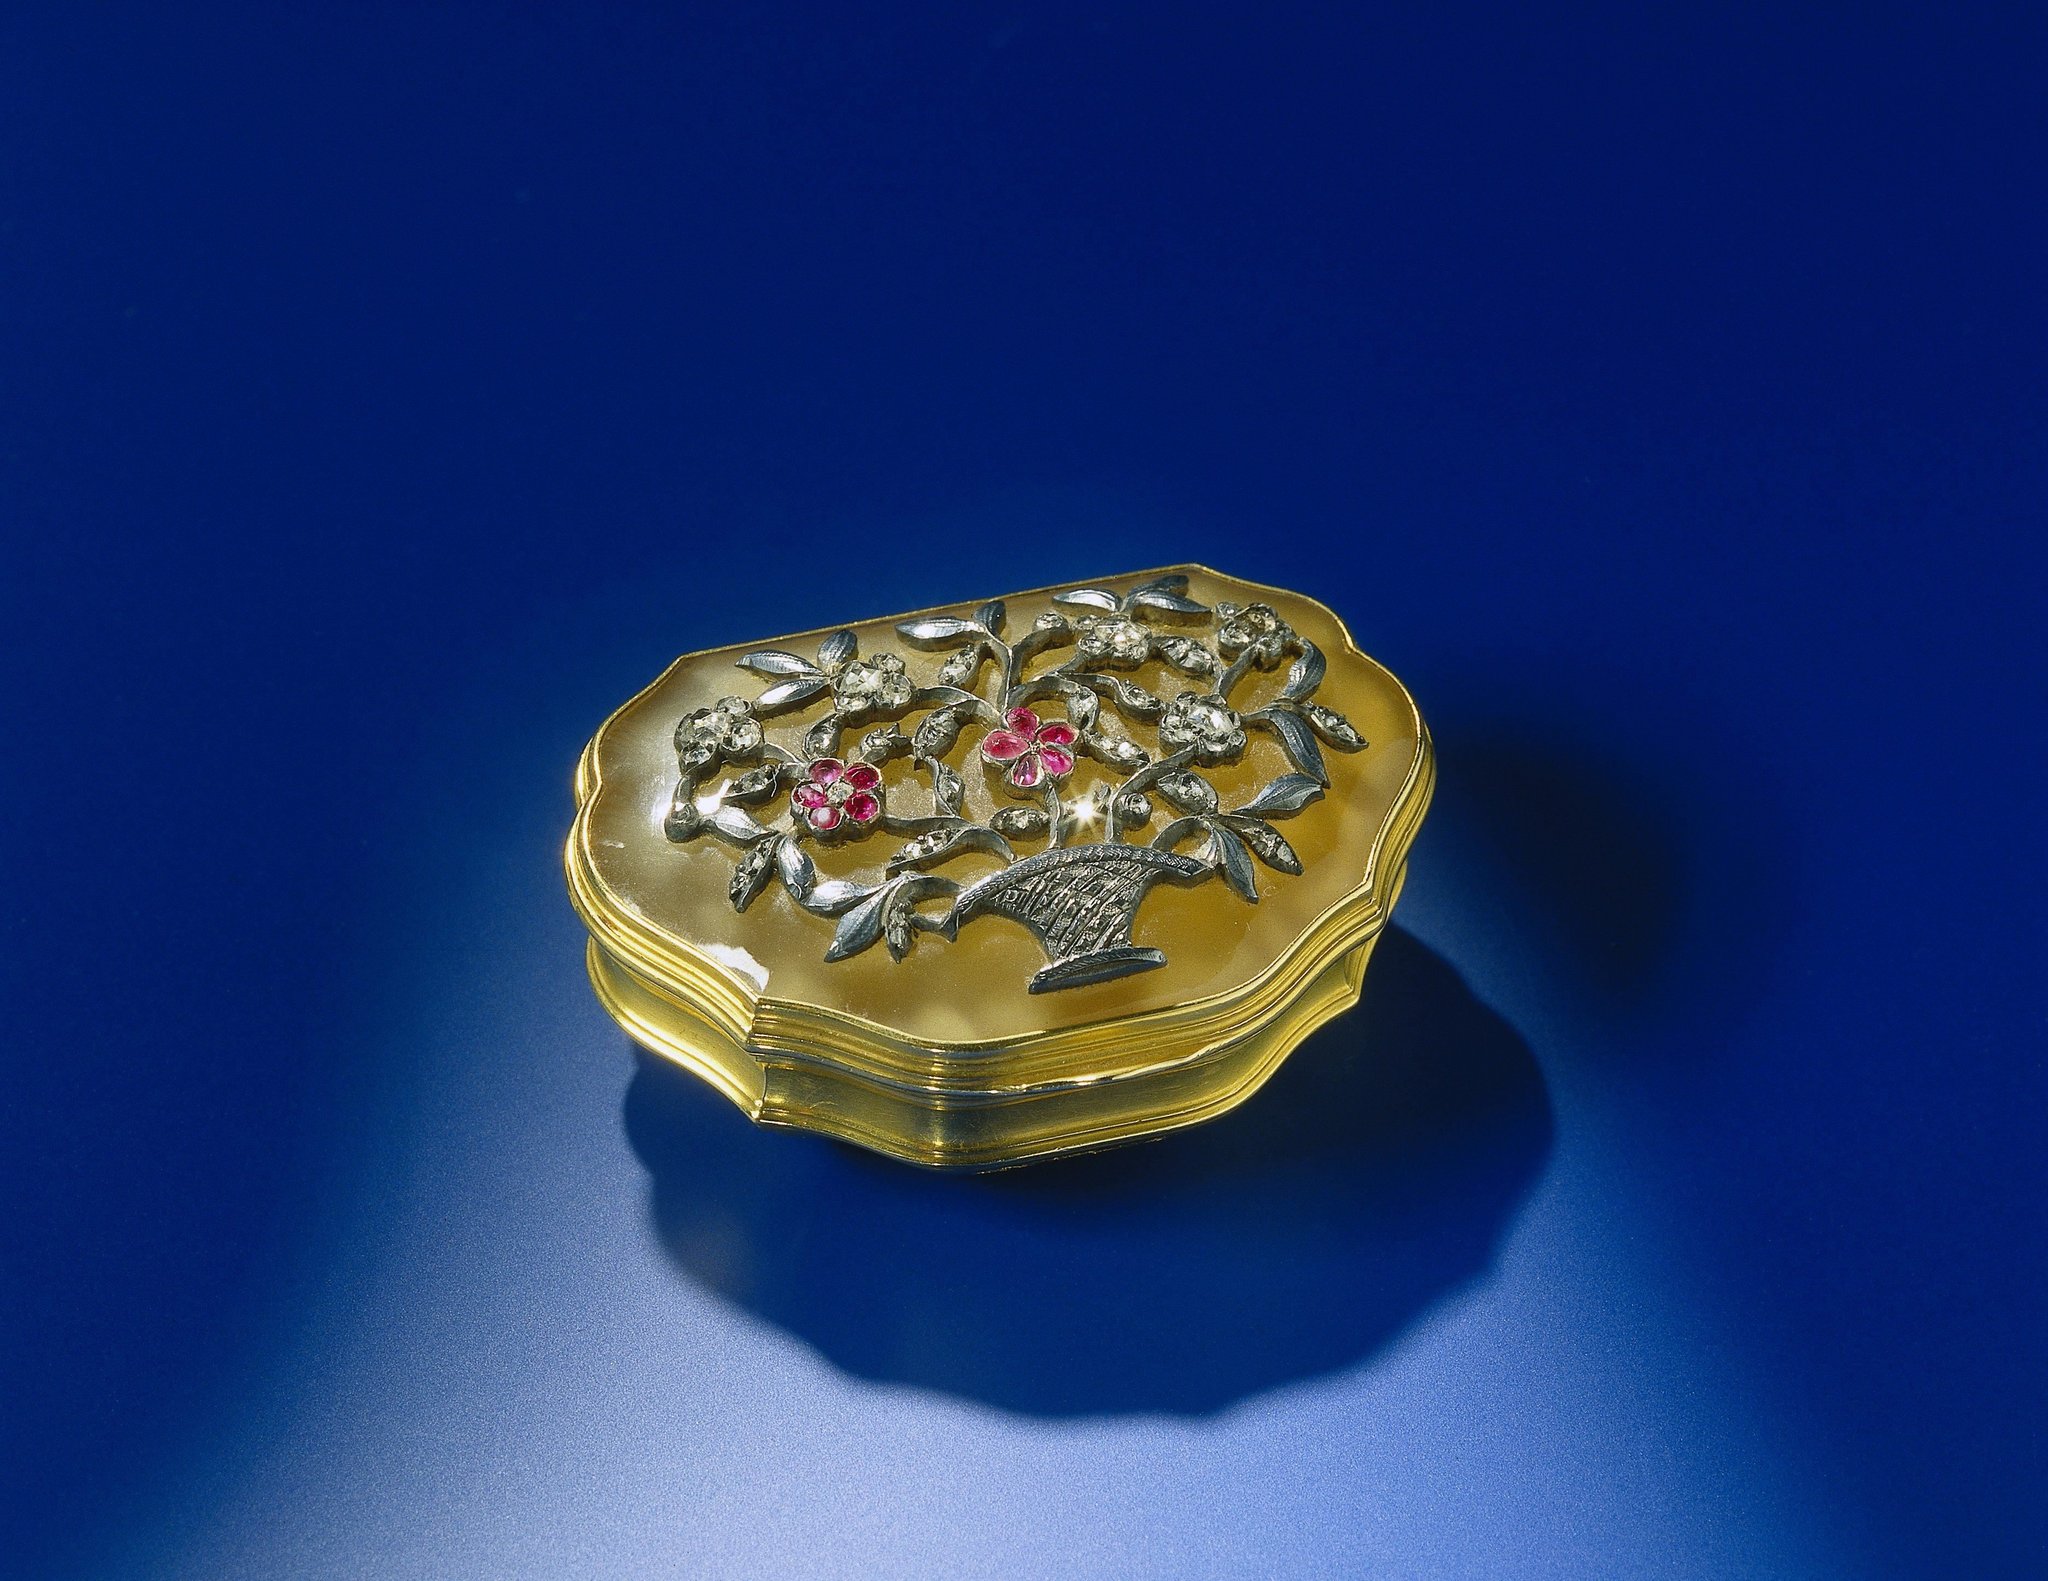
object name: snuffbox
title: Snuifdoos van goud met deksel van chalcedoon. De geschulpte doos is versierd met een bloemenmand in reliëf van zilver, met diamanten en robijnen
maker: jean saint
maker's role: goldsmith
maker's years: 1698-1769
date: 1739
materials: stone, diamond, gold, gemstone, silver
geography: amsterdam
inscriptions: town mark, alloy mark, maker's mark, date letter: ‘E’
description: Snuffbox. Gold, chalcedony, silver, diamonds and rubies. Amsterdam, 1739, by Jean Saint. Snuffbox. Gold. Amsterdam, 1739, by Jean Saint.